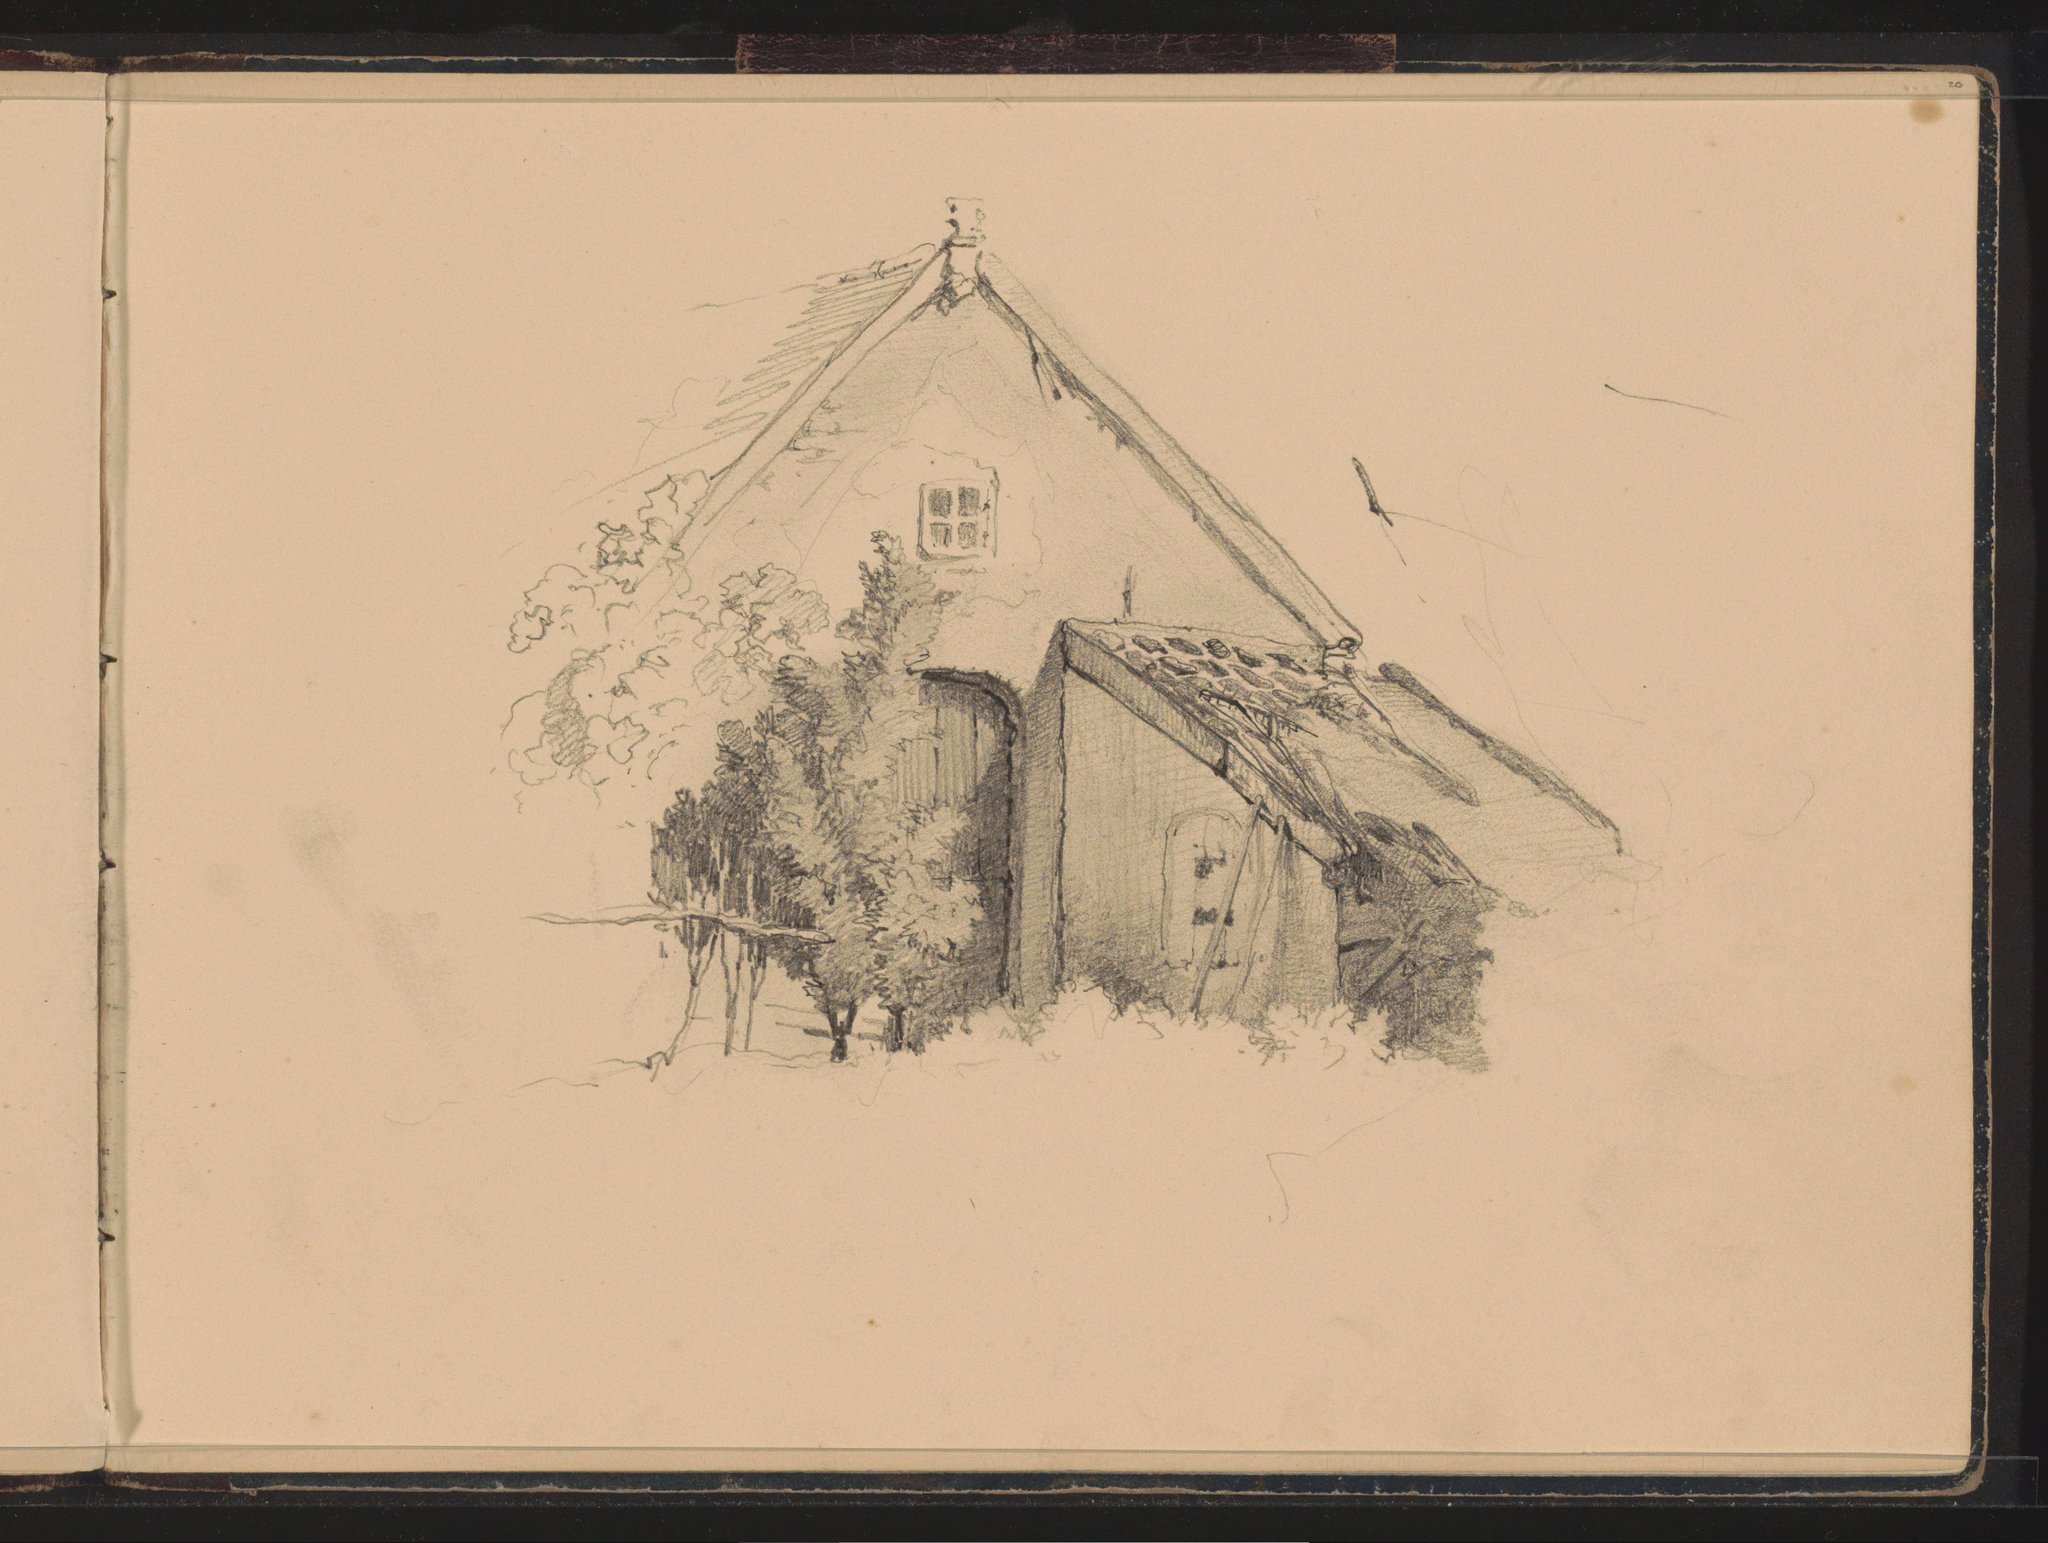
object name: sketchbook leaf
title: Plattelandswoning met een schuur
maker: maria vos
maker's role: draughtsman, painter, print maker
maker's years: 1824-1906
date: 1864-1865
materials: paper, pencil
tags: rural housing, e.g. country-house, villa, cottage, shed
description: Blad 20 recto uit een schetsboek met 44 bladen.